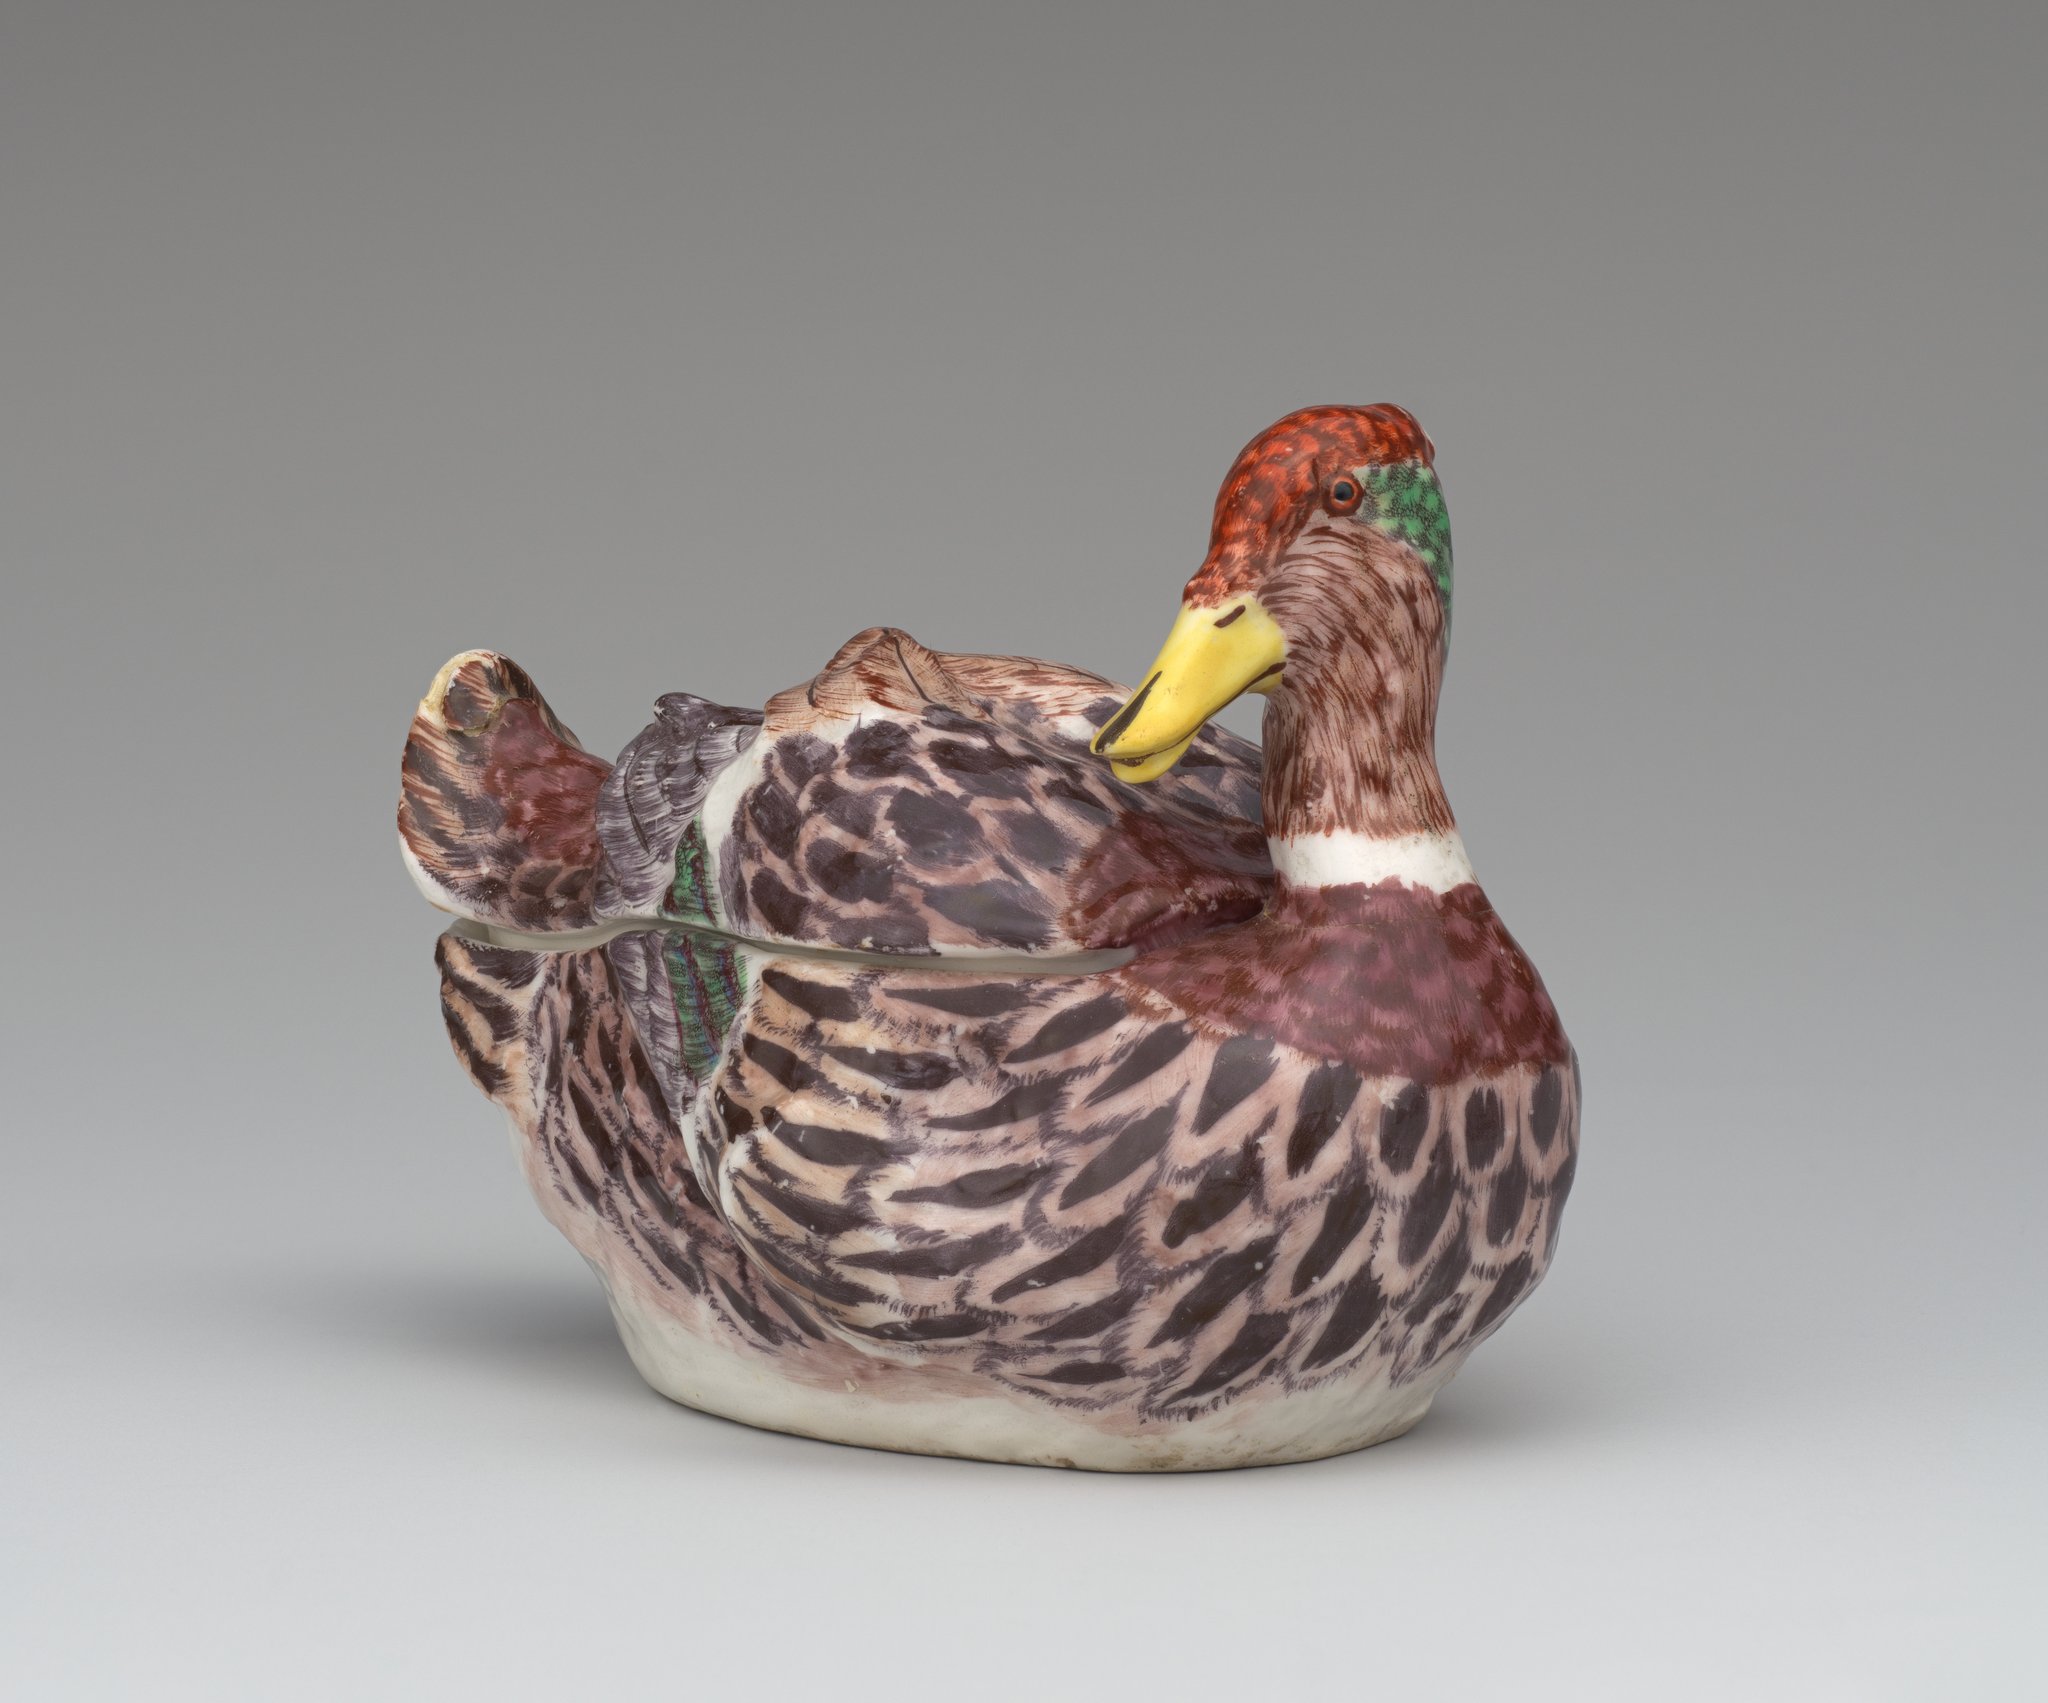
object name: tureen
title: Miniature tureen in the form of a duck (one of a pair)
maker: bow porcelain factory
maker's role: factory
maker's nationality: british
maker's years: 1747-1776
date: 1752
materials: soft paste porcelain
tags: ducks